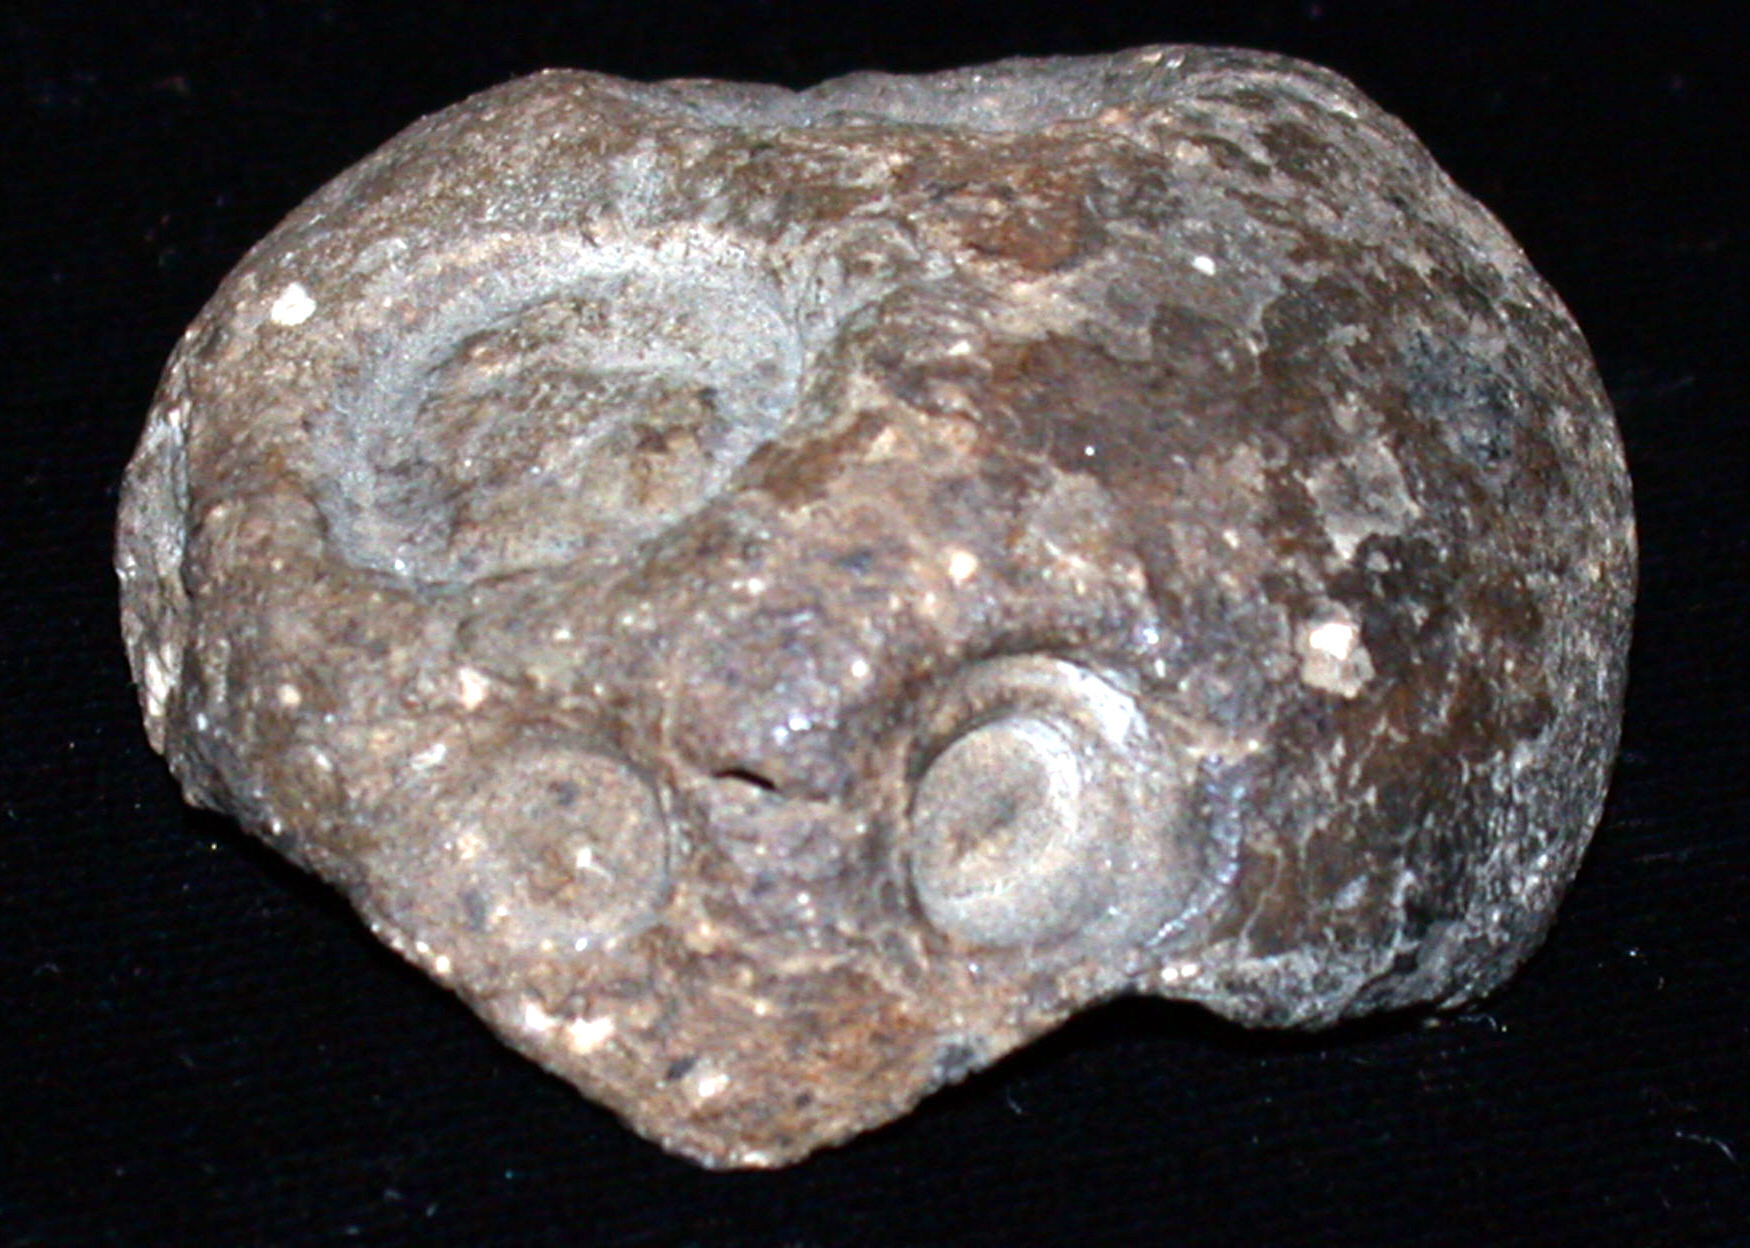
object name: sealing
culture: sasanian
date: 601-700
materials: clay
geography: iran